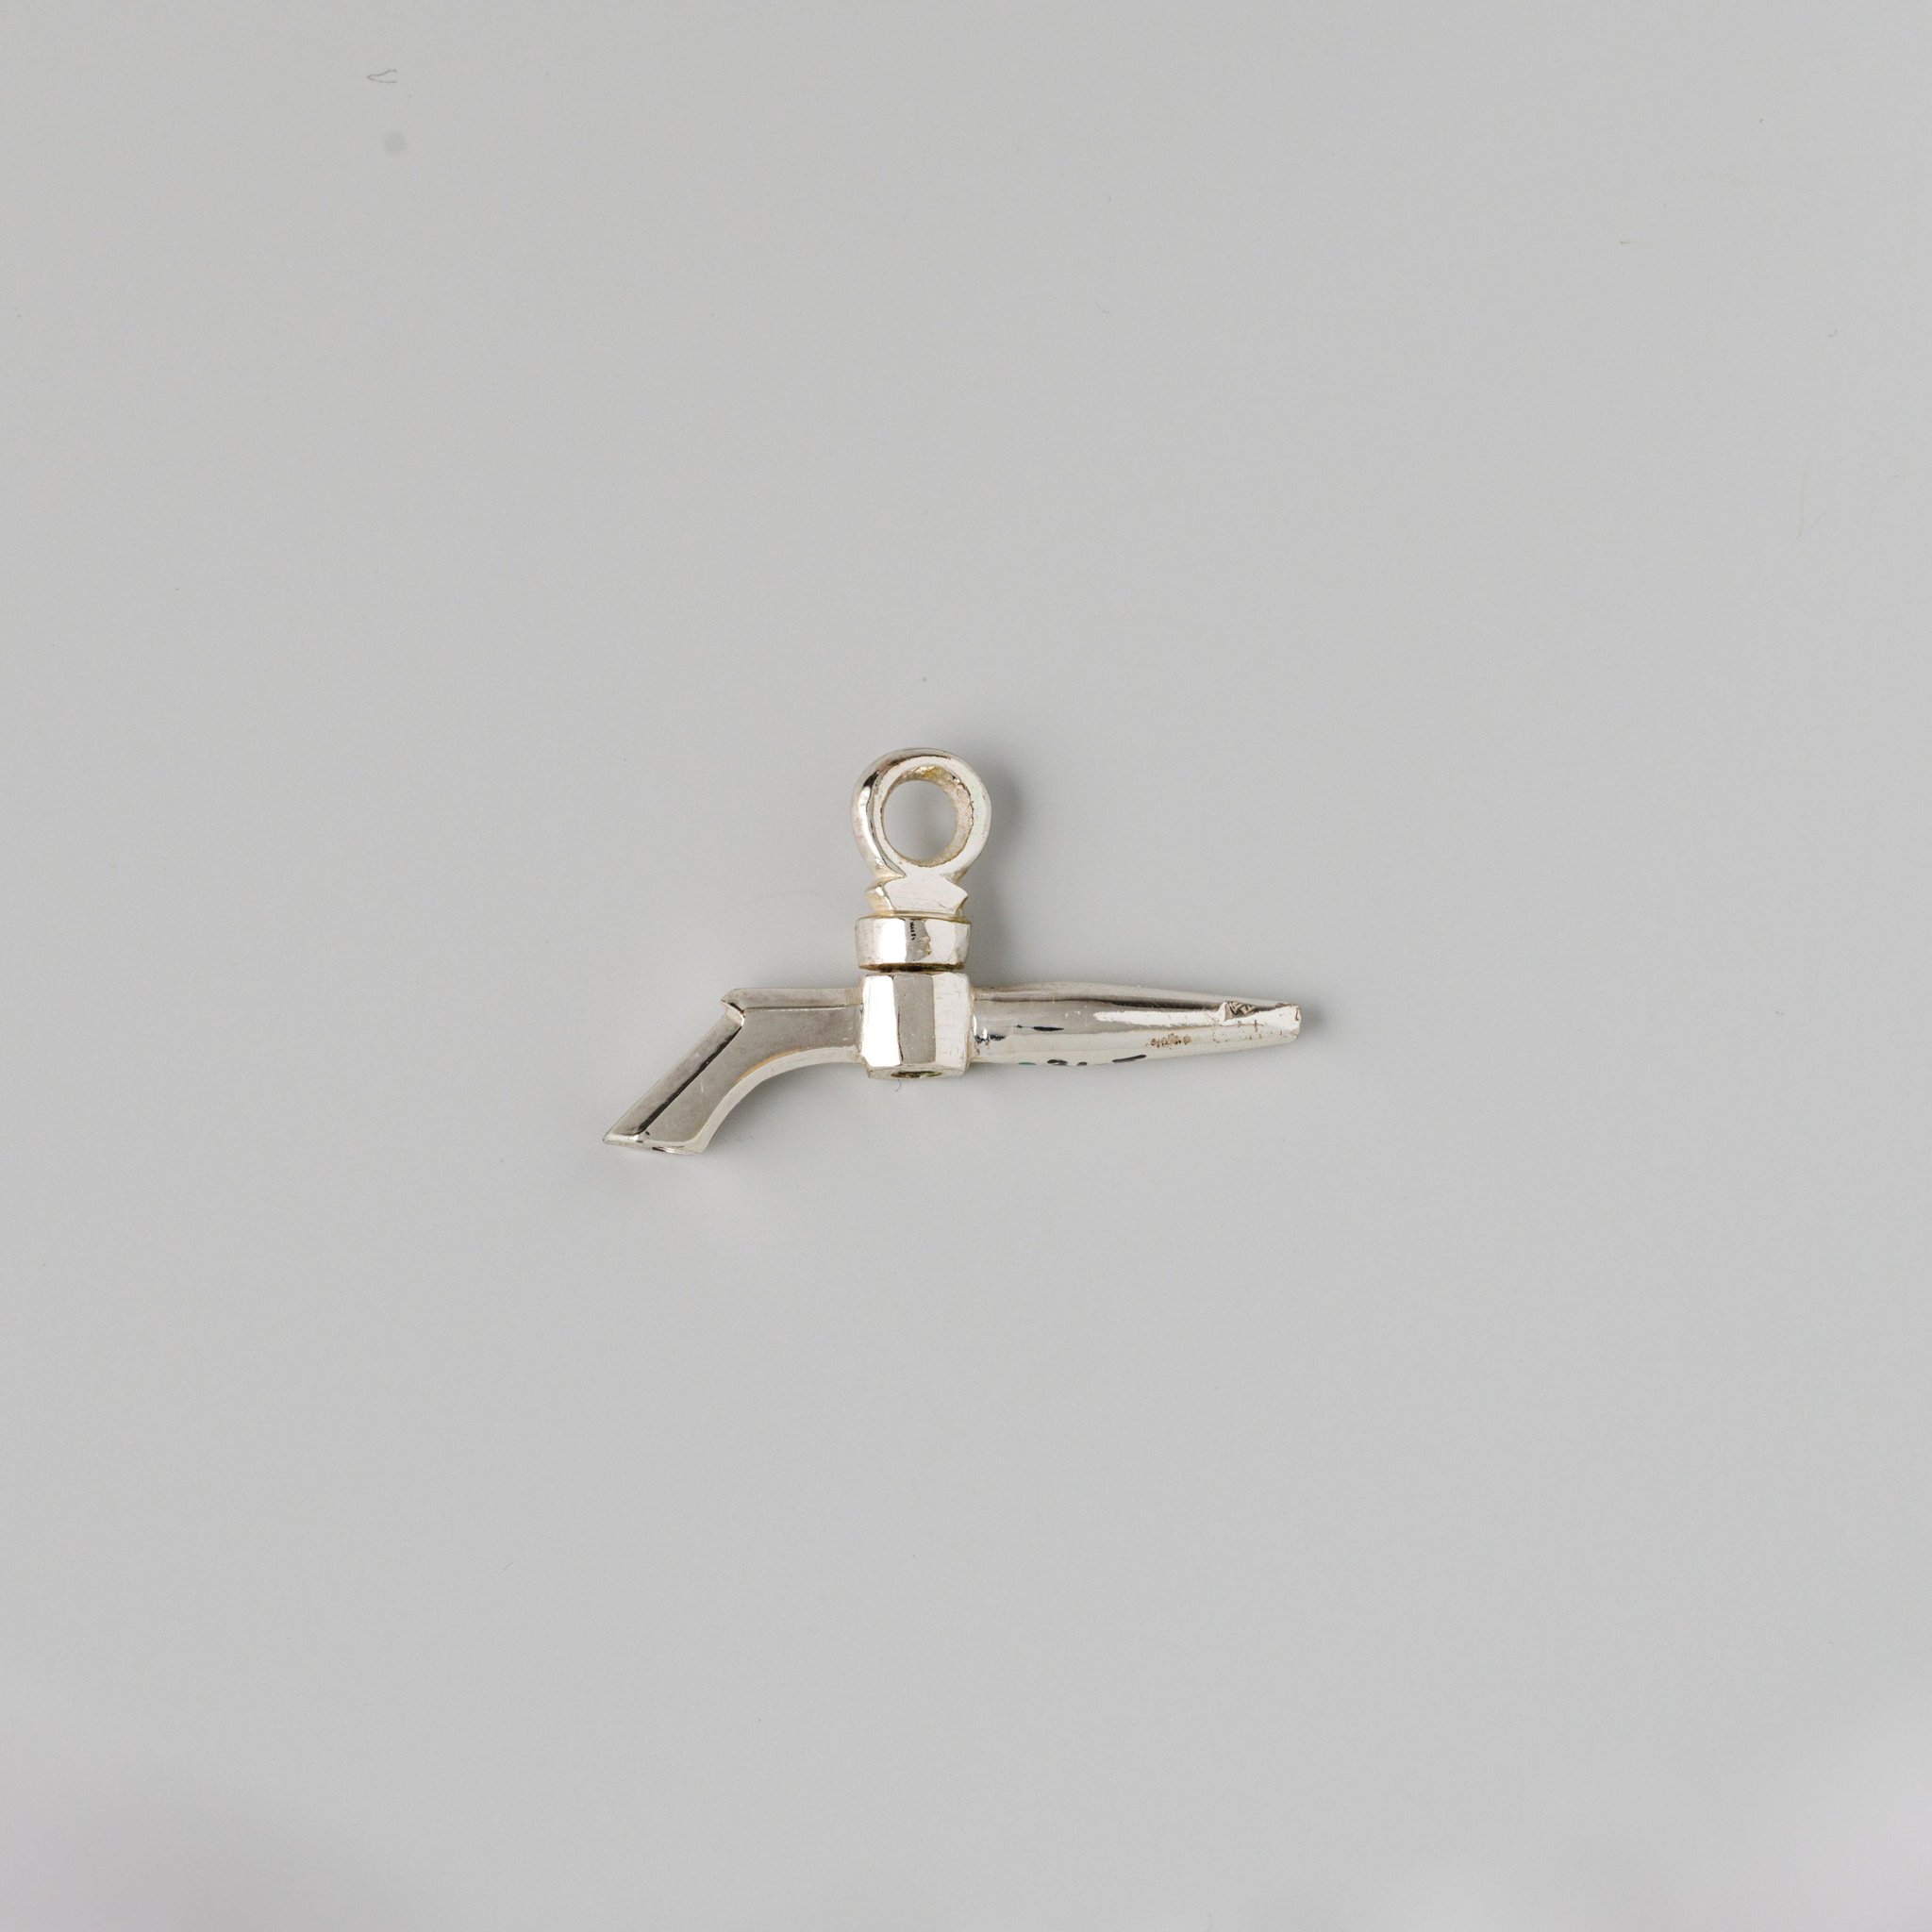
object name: spigot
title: Kraan van zilver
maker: Anonymous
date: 1675-1700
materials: silver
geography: amsterdam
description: Kraan van zilver met open-dicht draaibare stop en ringvormig handvat.